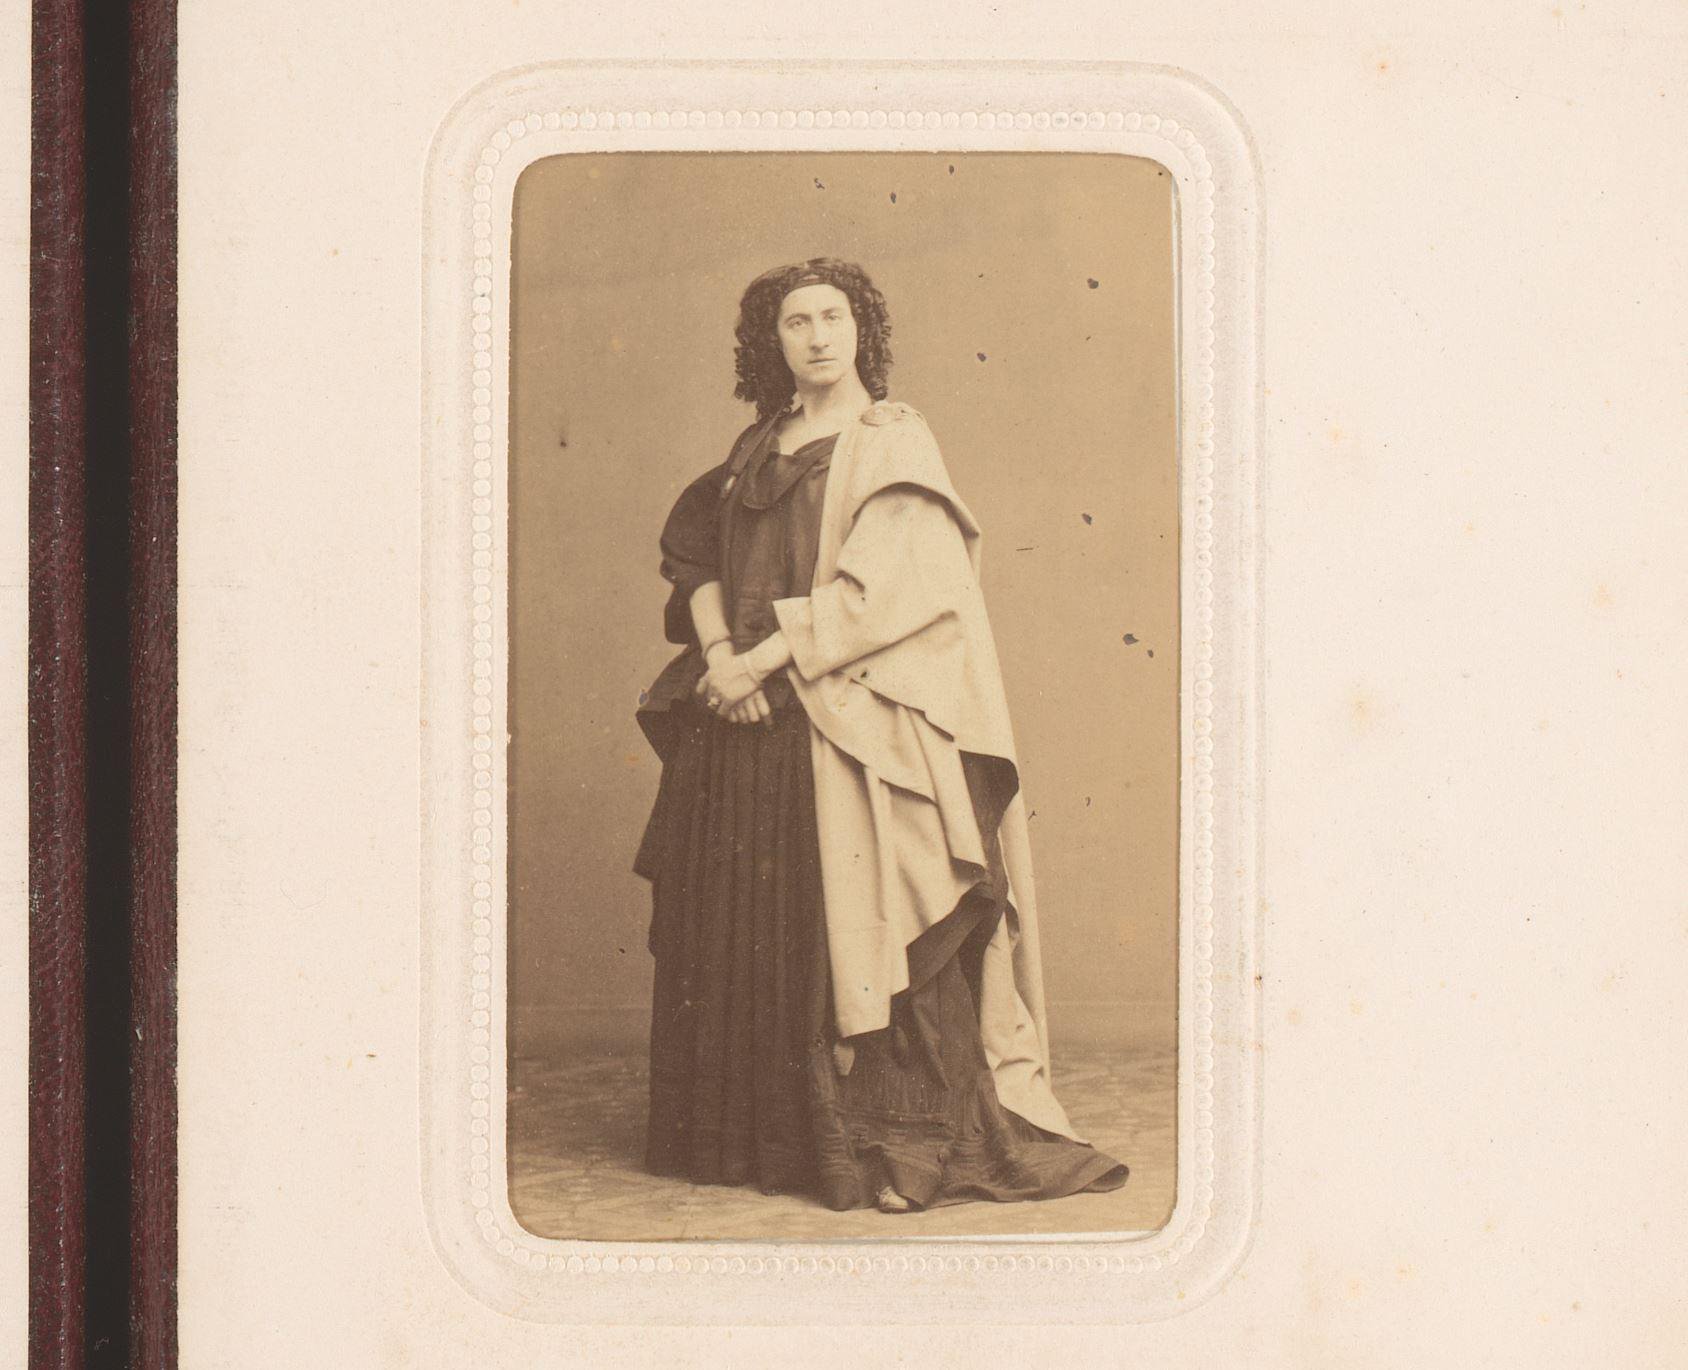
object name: photograph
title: Portret van een acteur, gekleed als vrouw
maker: andré-adolphe-eugène disdéri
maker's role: fotograaf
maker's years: 1819-1889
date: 1860-1890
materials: cardboard, photographic support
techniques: albumen print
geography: paris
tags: man dressed as woman, travesty, portrait of actor, actress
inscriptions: inscription: ‘DISDÉRI/ PHOTOGRAPHE de S. M. L'EMPEREUR/ 3, BoulevarT des Italiens/ PARIS’